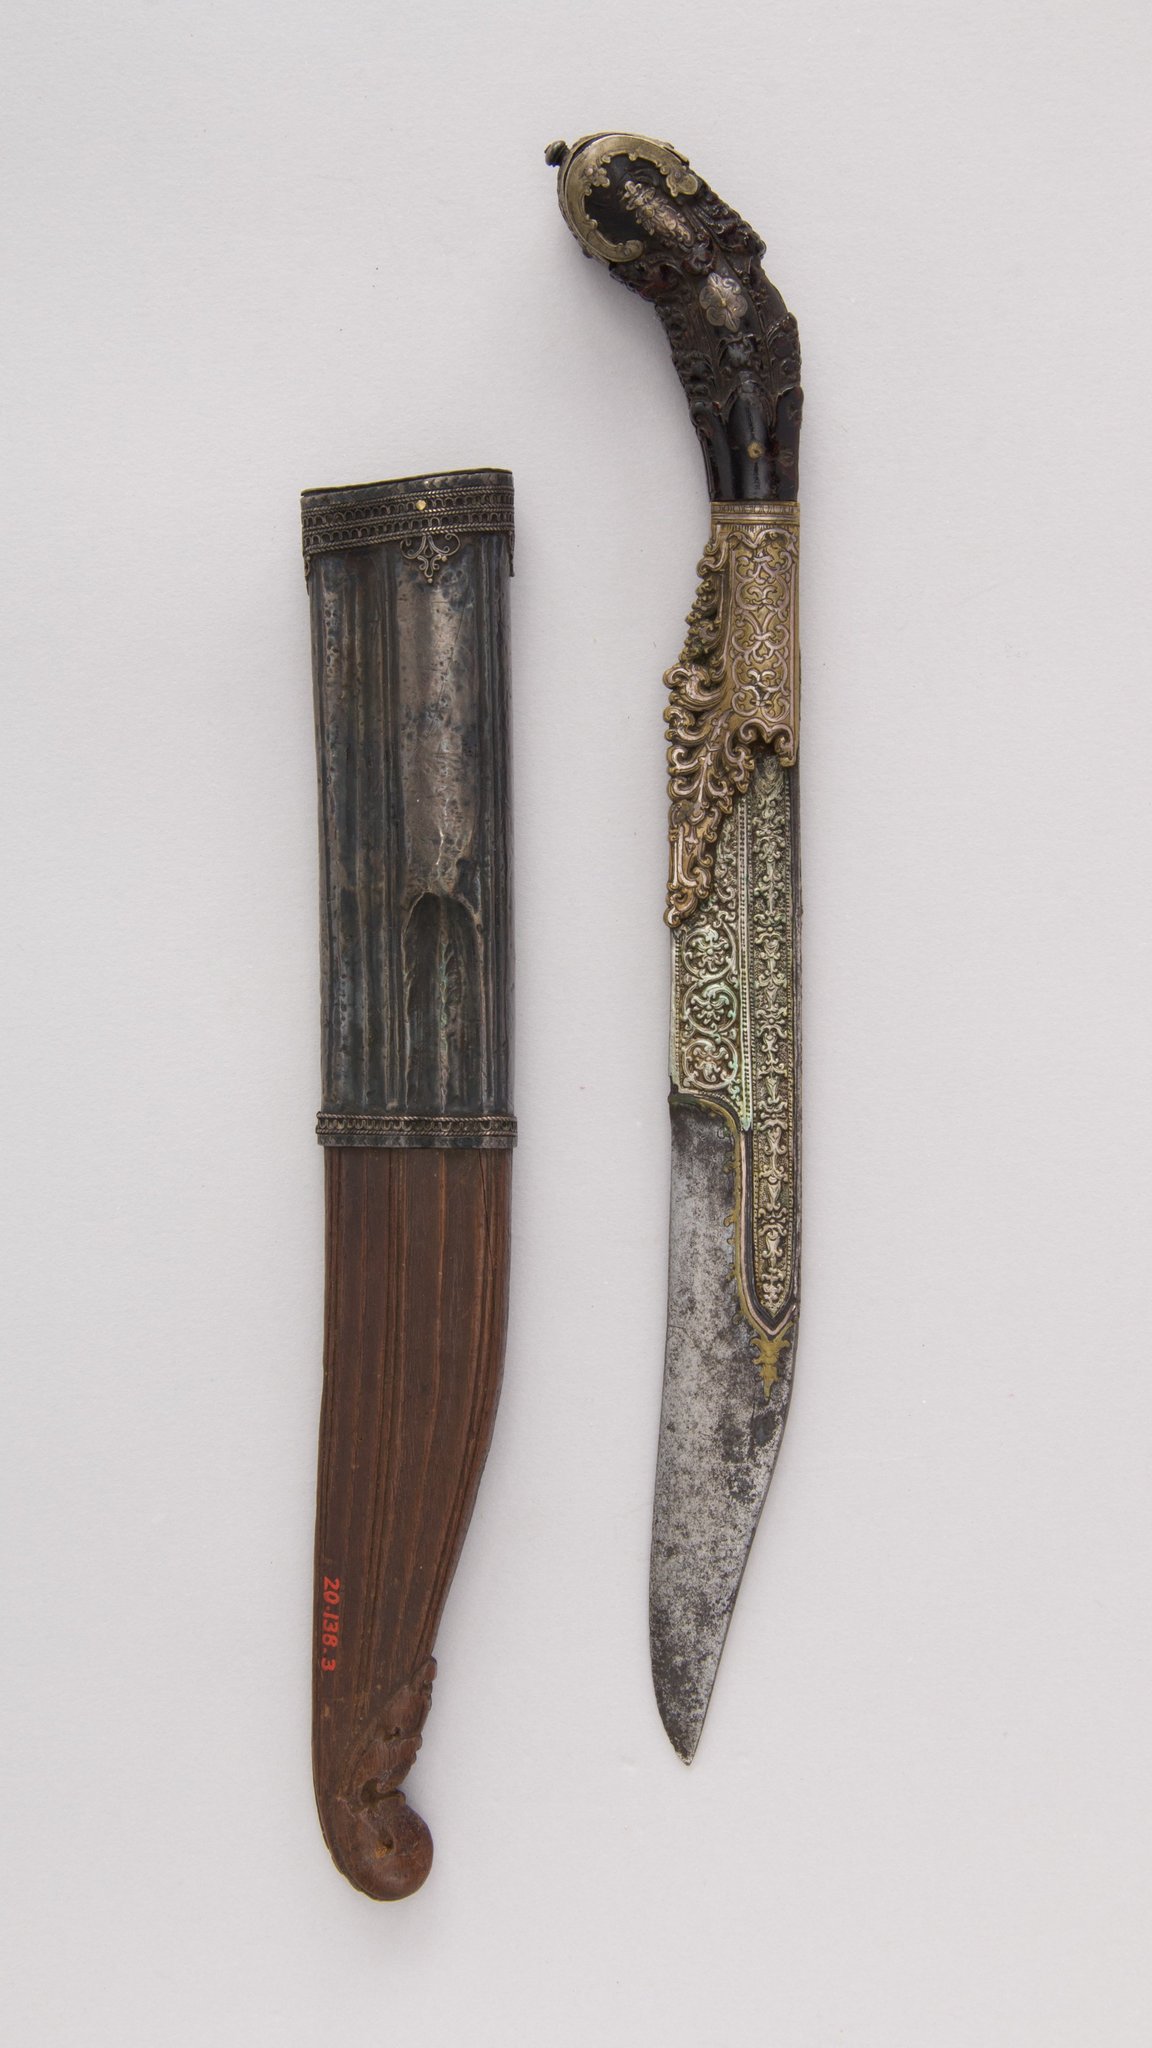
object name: knife piha kaetta with sheath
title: Knife (Piha Kaetta) with Sheath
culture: sri lankan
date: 1701-1800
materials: brass, horn, silver, steel, wood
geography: sri lanka